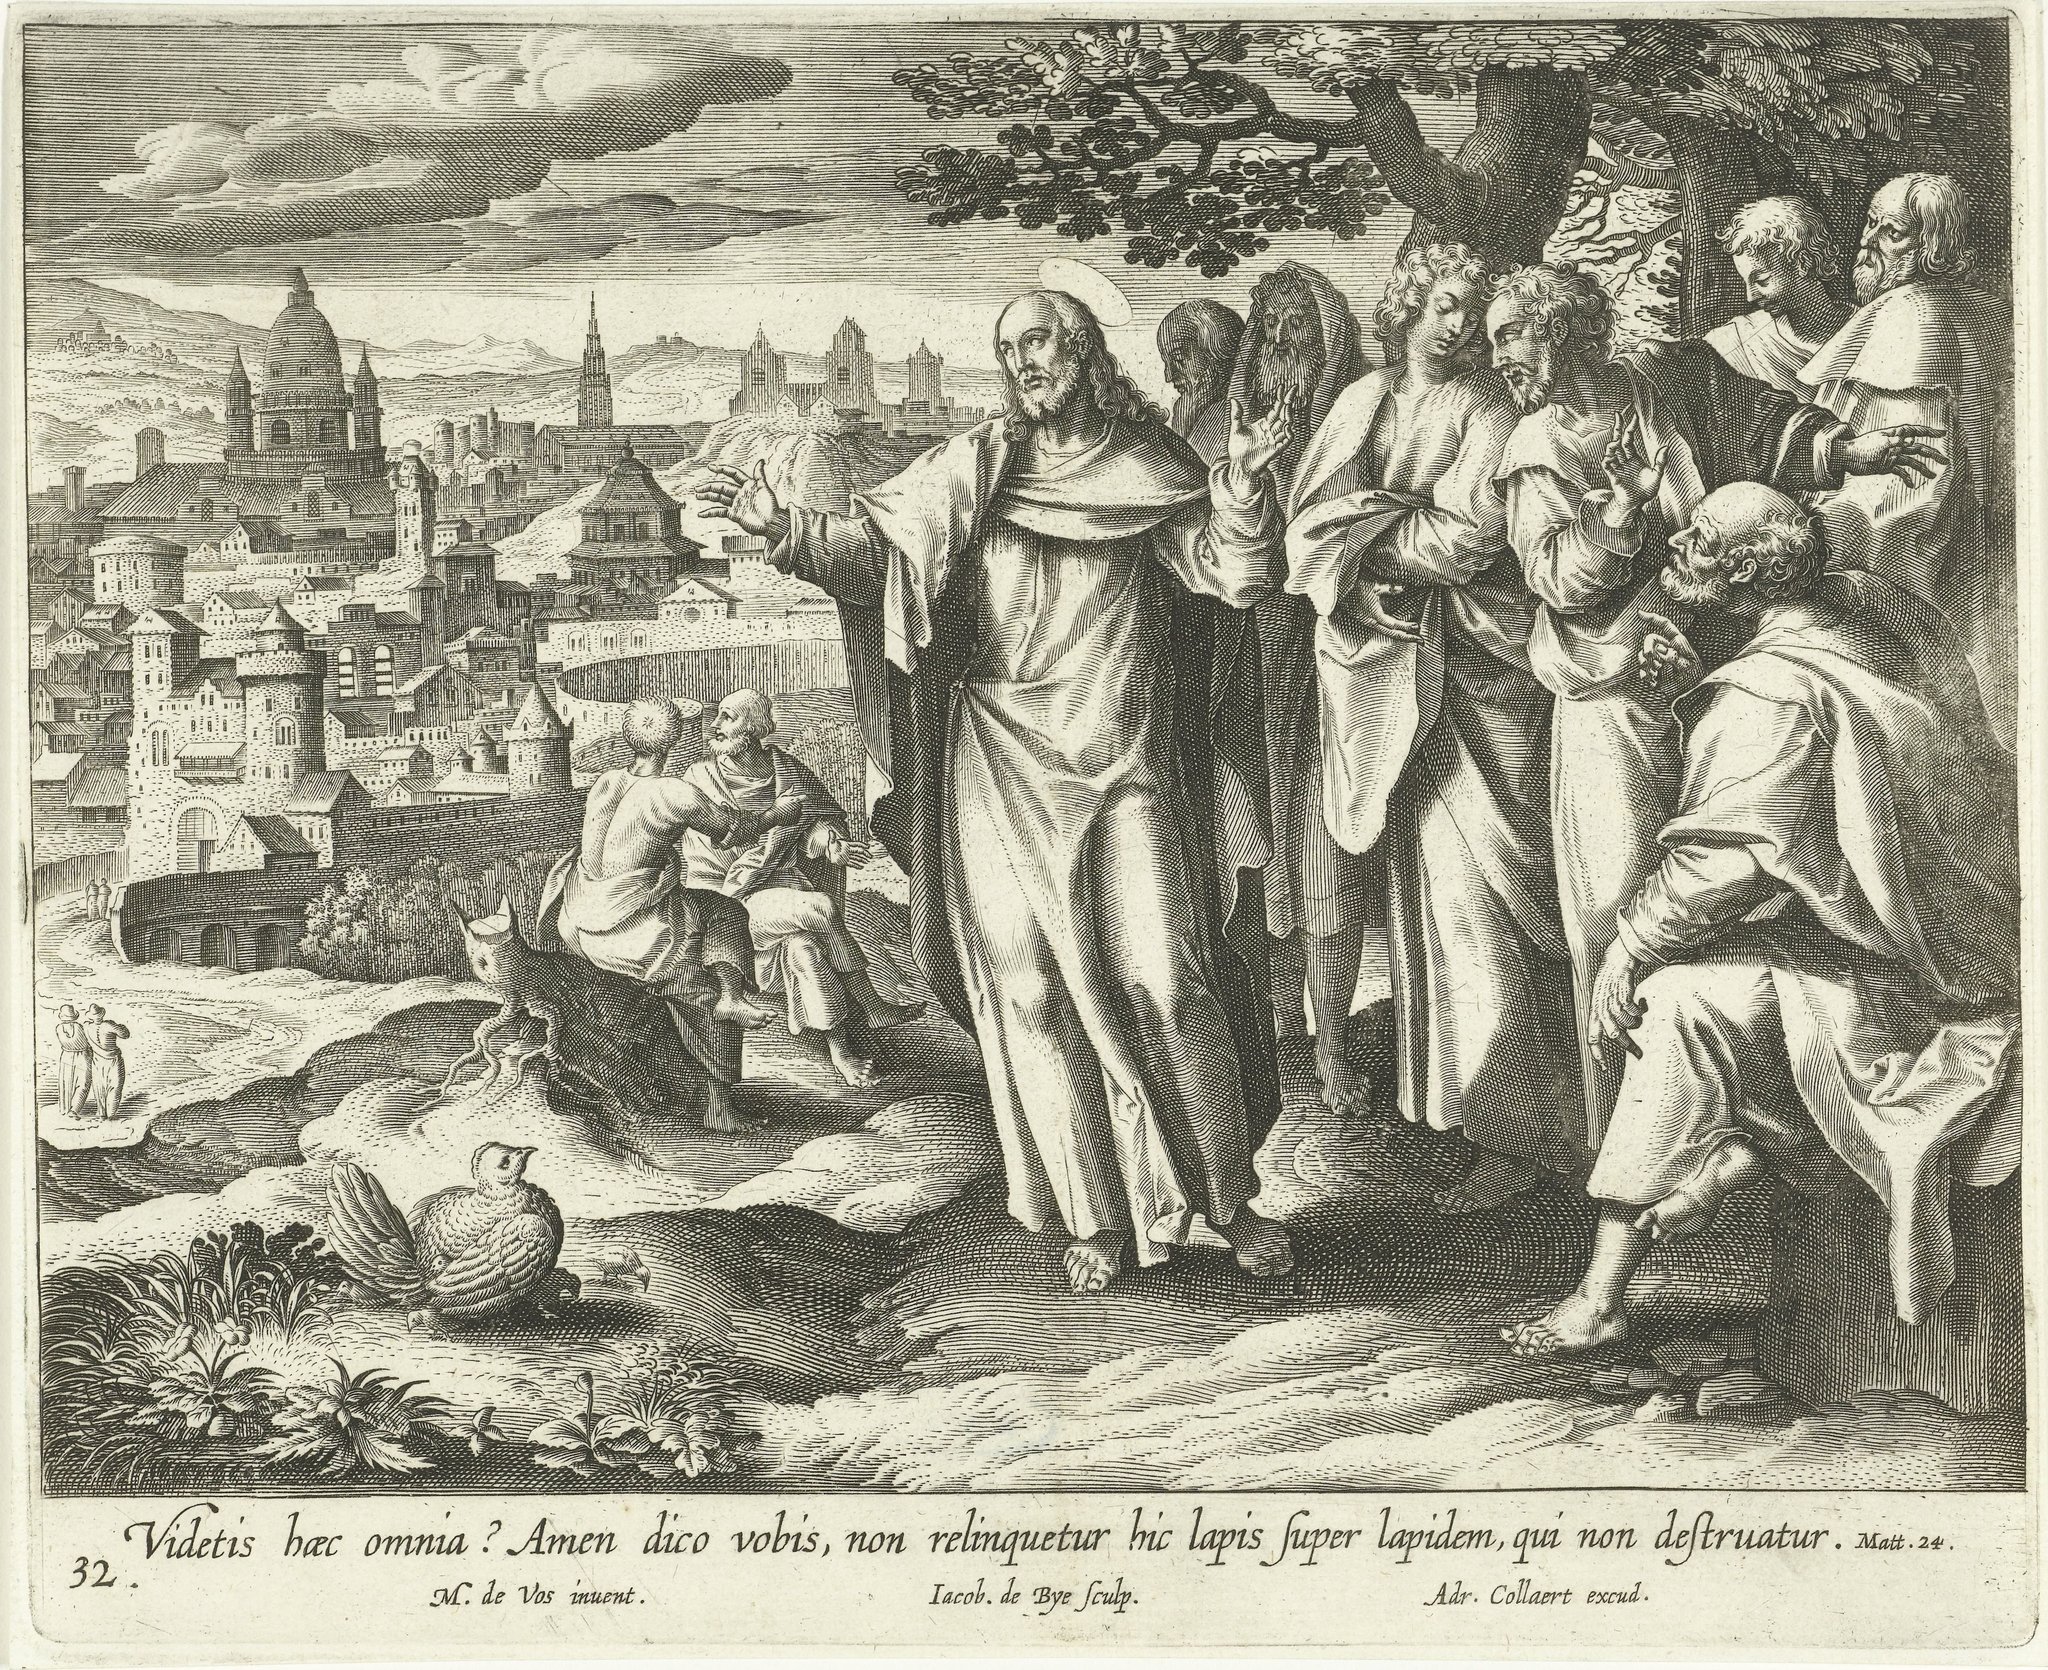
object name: print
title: Christus voorspelt de vernietiging van Jeruzalem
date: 1598-1618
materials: paper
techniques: engraving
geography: antwerp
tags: christ mourning over jerusalem and its future destruction (luke 19:41-44)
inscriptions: collector's mark: Lugt 2228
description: Christus staat met zijn leerlingen aan de rand van de stad Jeruzalem. Hij voorspelt de vernietiging van Jeruzalem en de tempel (Matteüs 24:1-2). De prent heeft een Latijns onderschrift. De prent maakt deel uit van een serie over het leven van Christus.